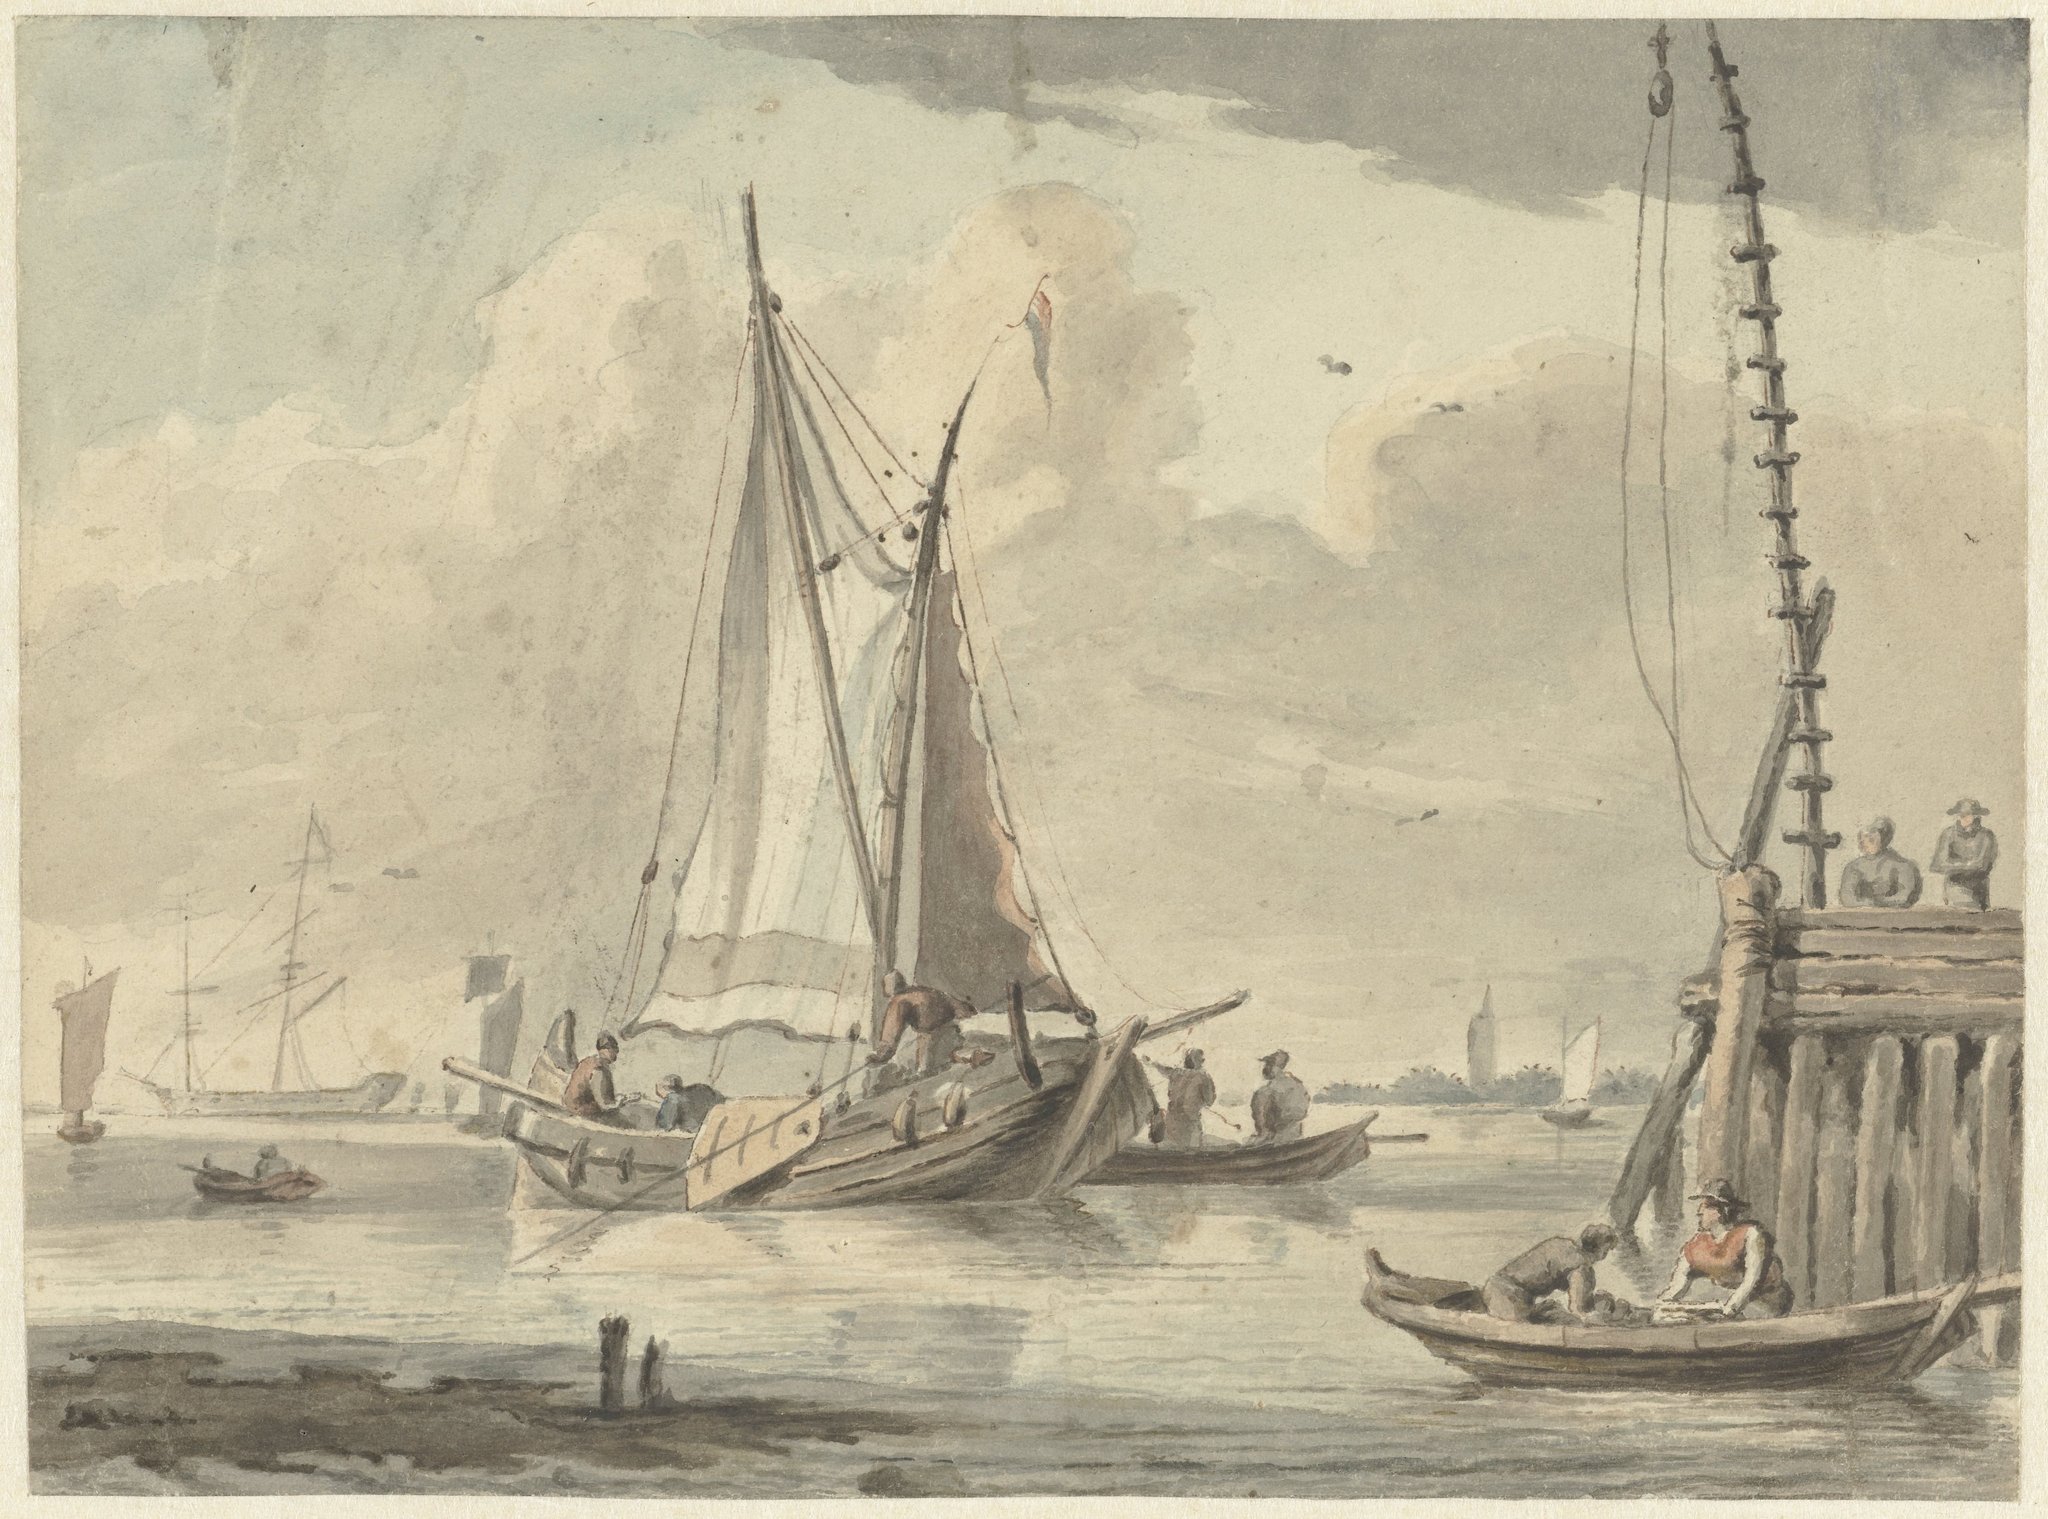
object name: watercolor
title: Zeilschepen op de rivier bij Dordrecht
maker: aert schouman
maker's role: draughtsman, painter, print maker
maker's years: 1710-1792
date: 1720-1792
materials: paper, watercolor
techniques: brush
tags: harbour, sailing-ship, sailing-boat, river, dordrecht